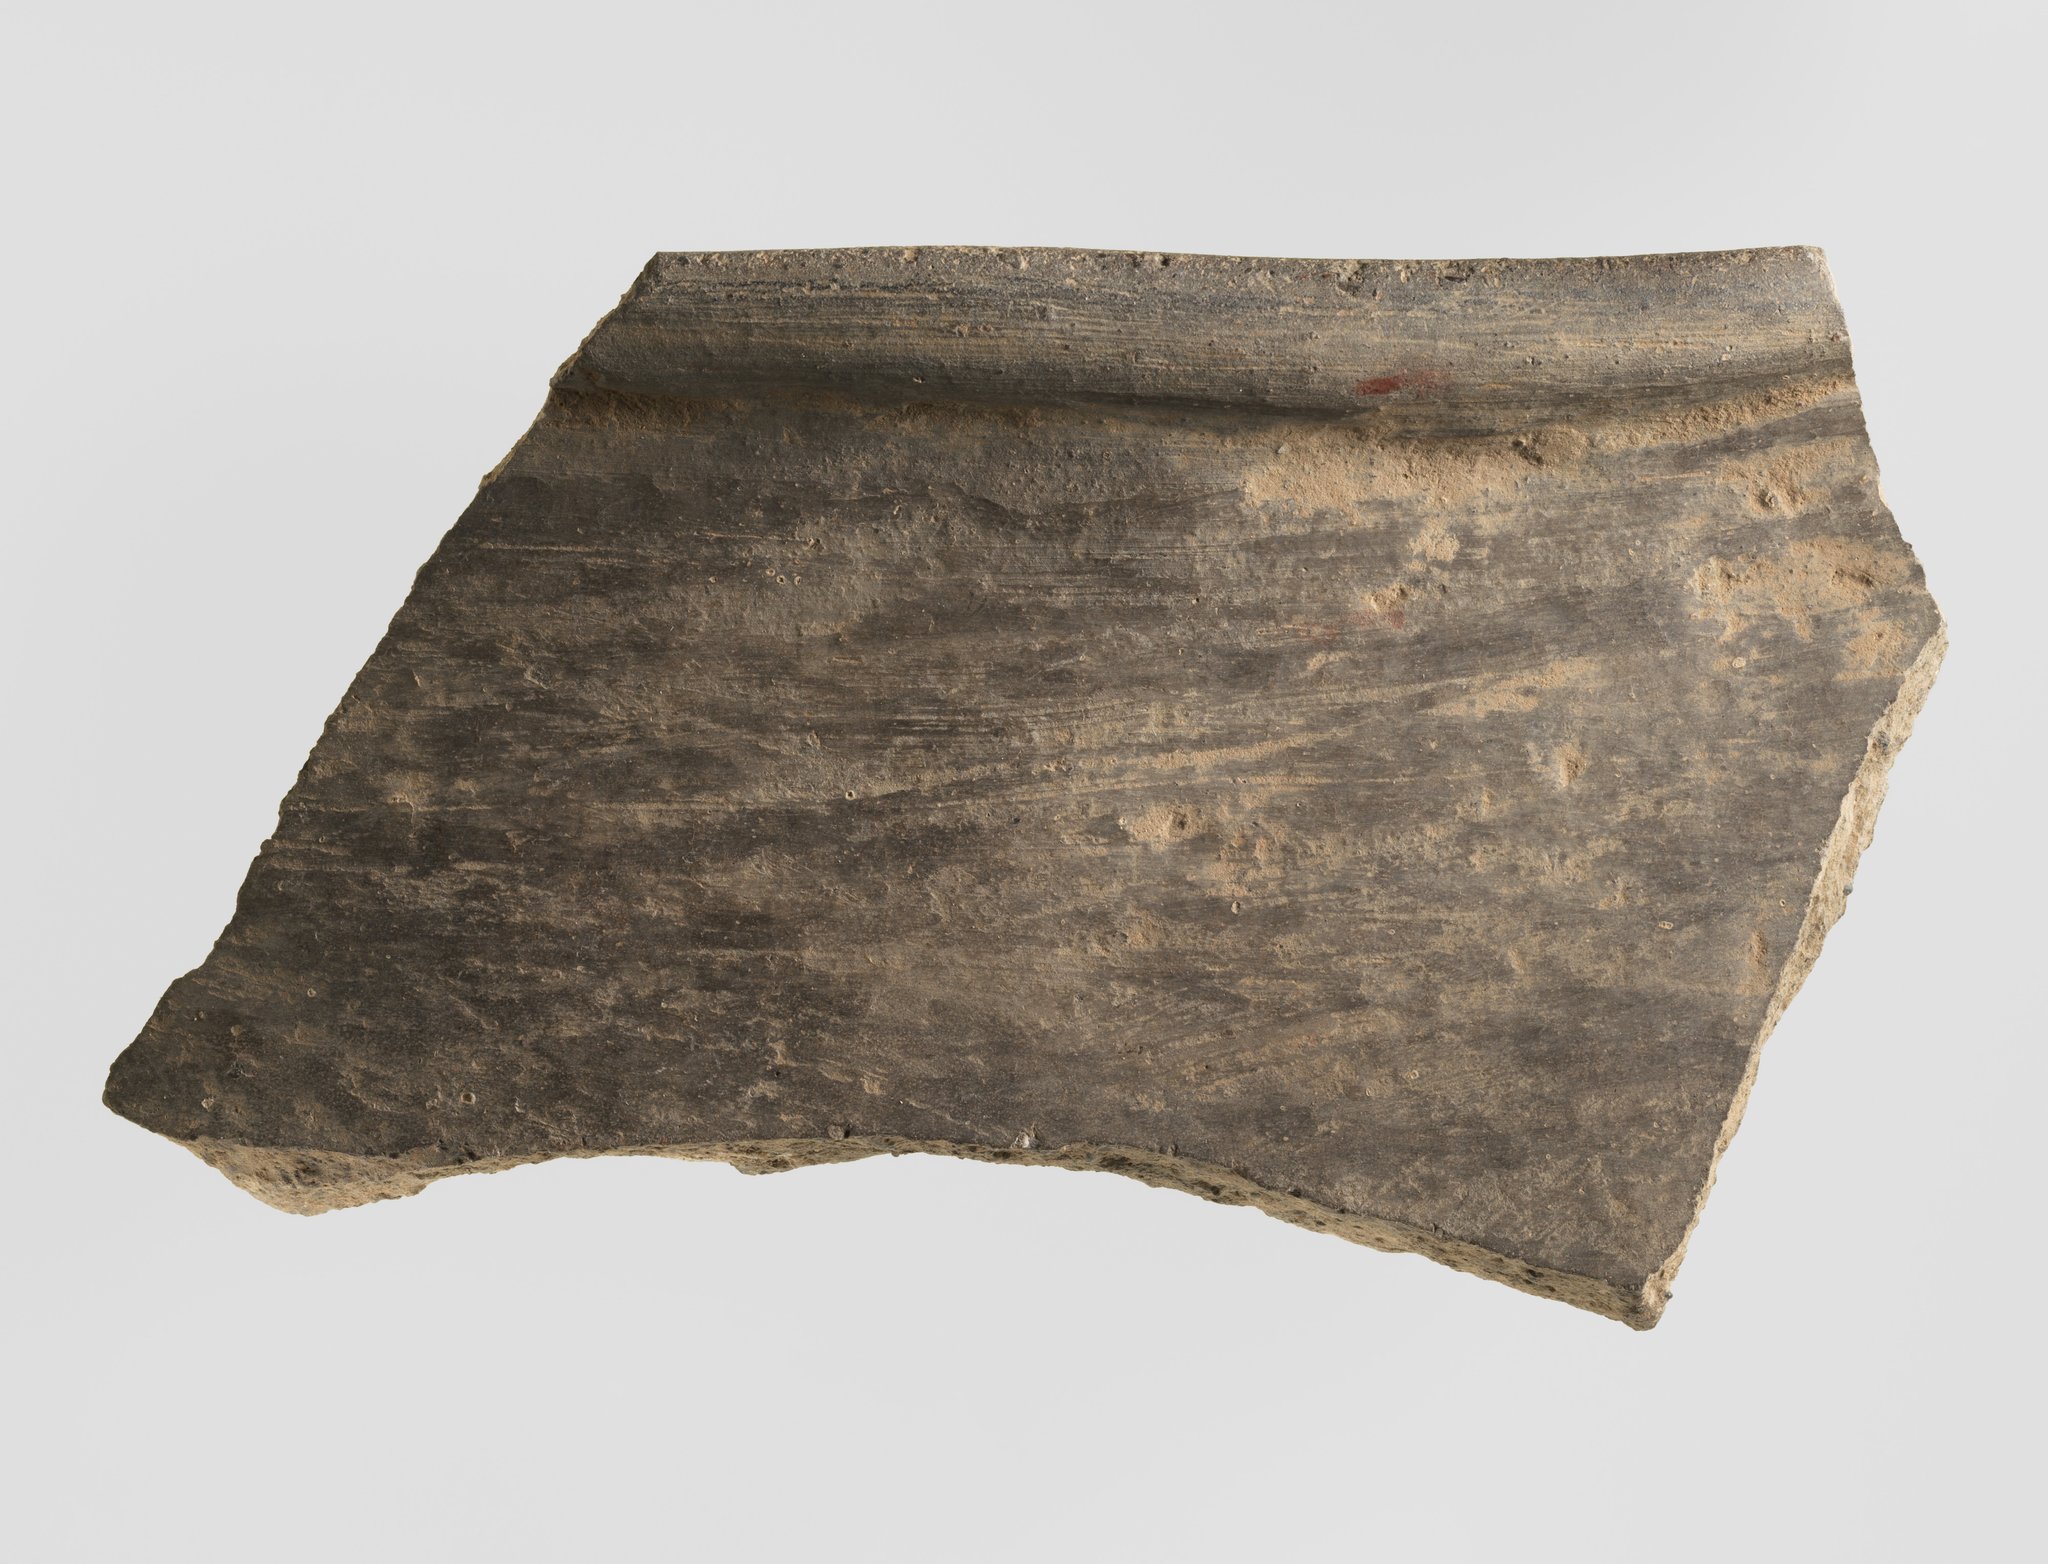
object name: sherd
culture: iranian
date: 3100-2500 BCE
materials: ceramic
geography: iran